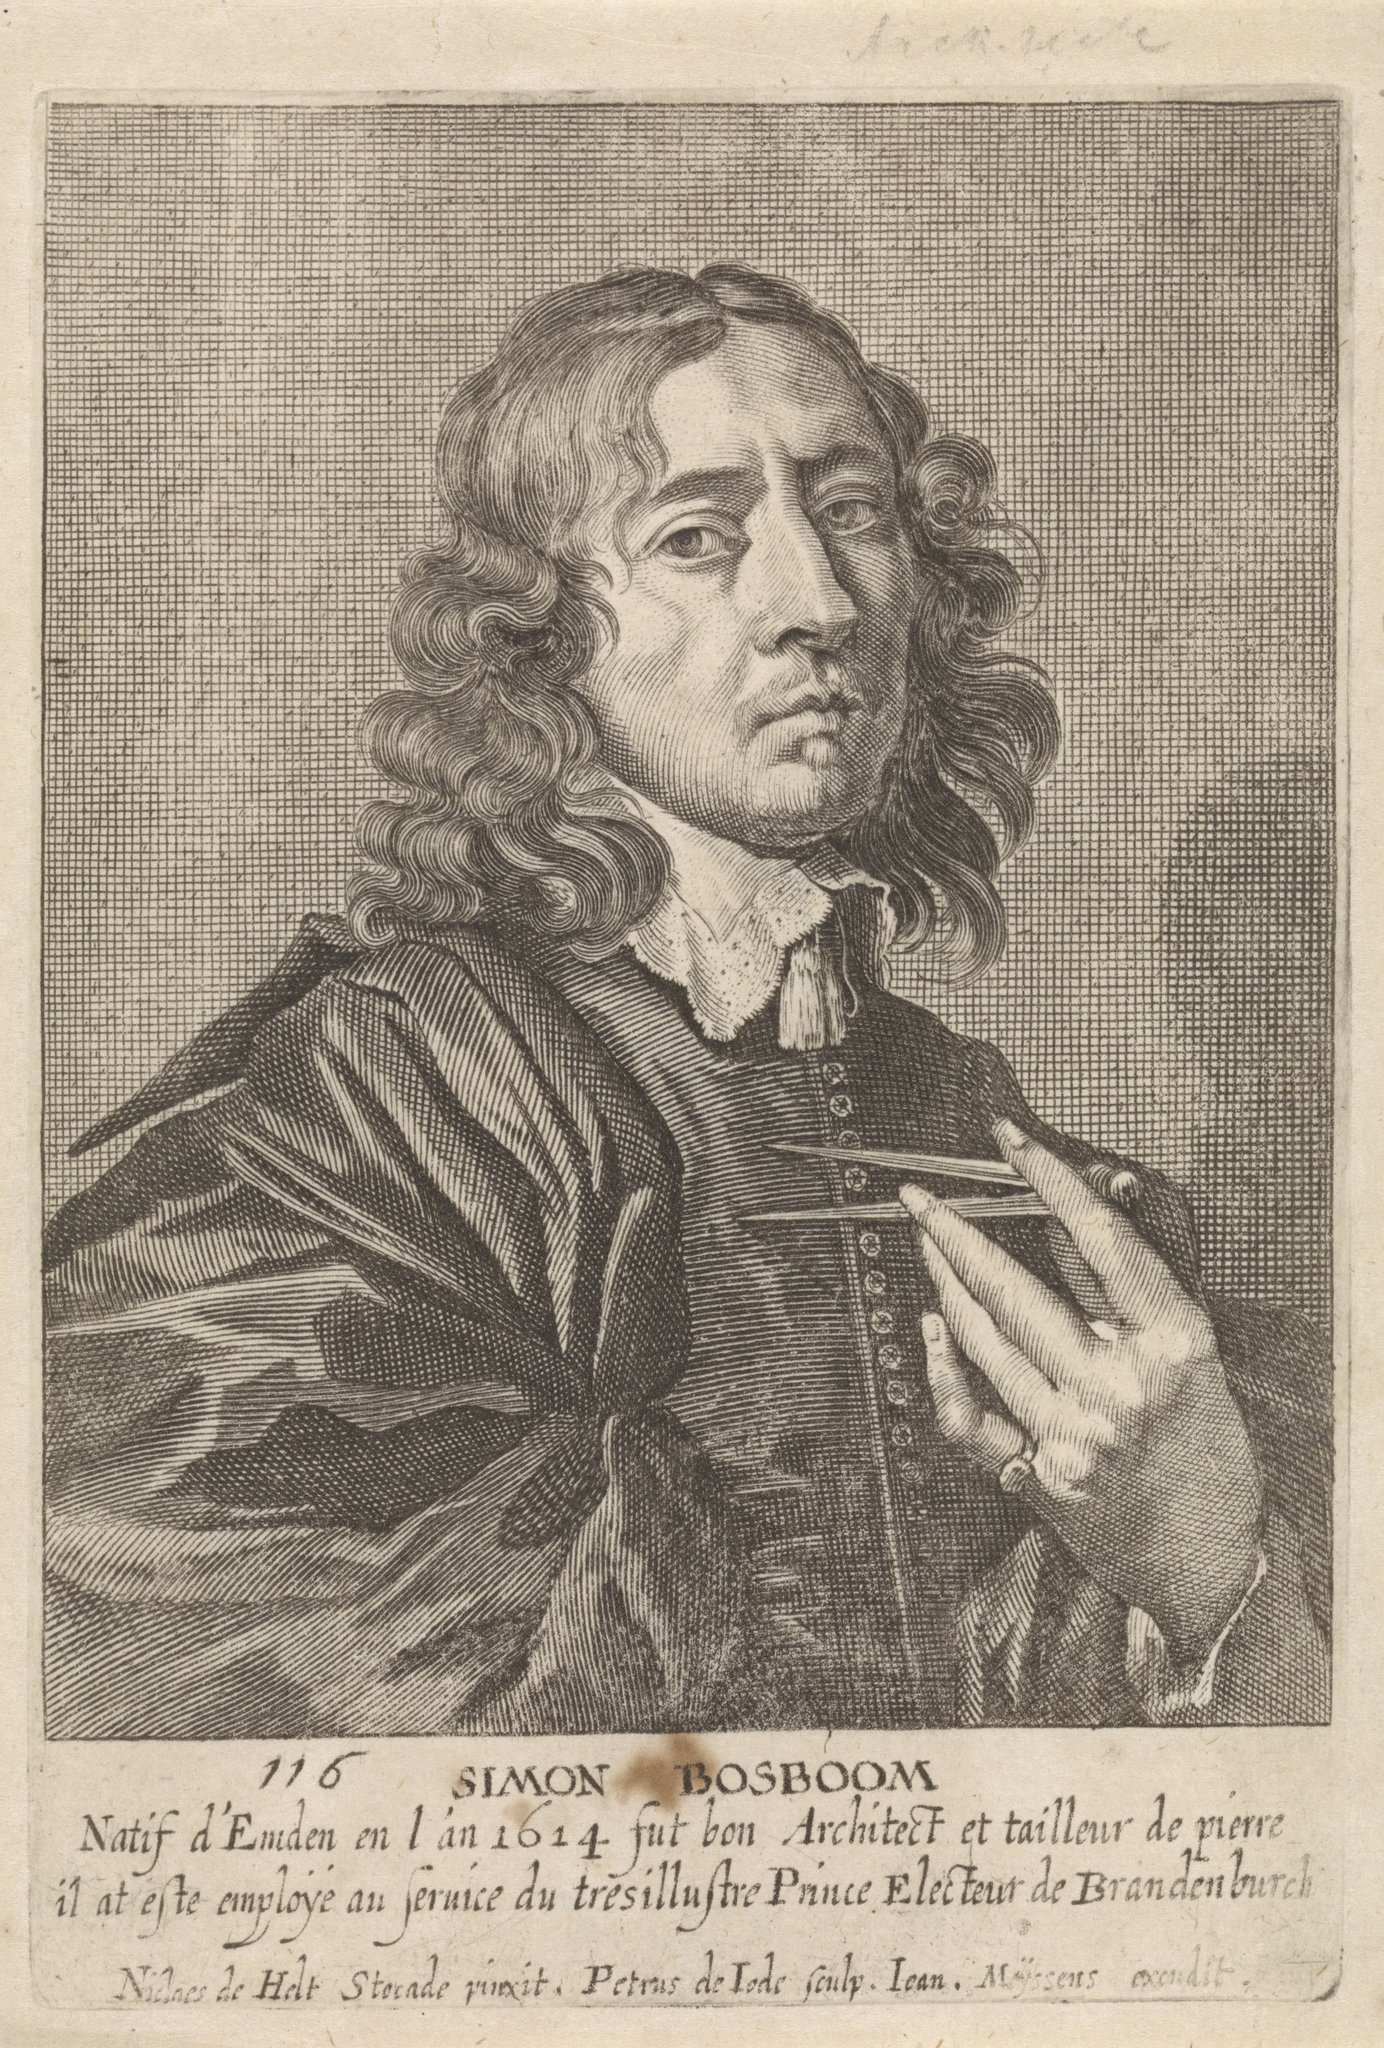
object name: print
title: Portret van Simon Bosboom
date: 1628-1670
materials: paper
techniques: engraving, etching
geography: antwerp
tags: amsterdam, compasses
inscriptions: collector's mark: Lugt 2228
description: Portret van de Duitse architect Simon Bosboom, ten halven lijve. Met zijn linkerhand houdt hij een passer tegen zijn borst aan. In de marge nummer 116, de naam van de geportretteerde en een tweeregelig onderschrift in het Frans.